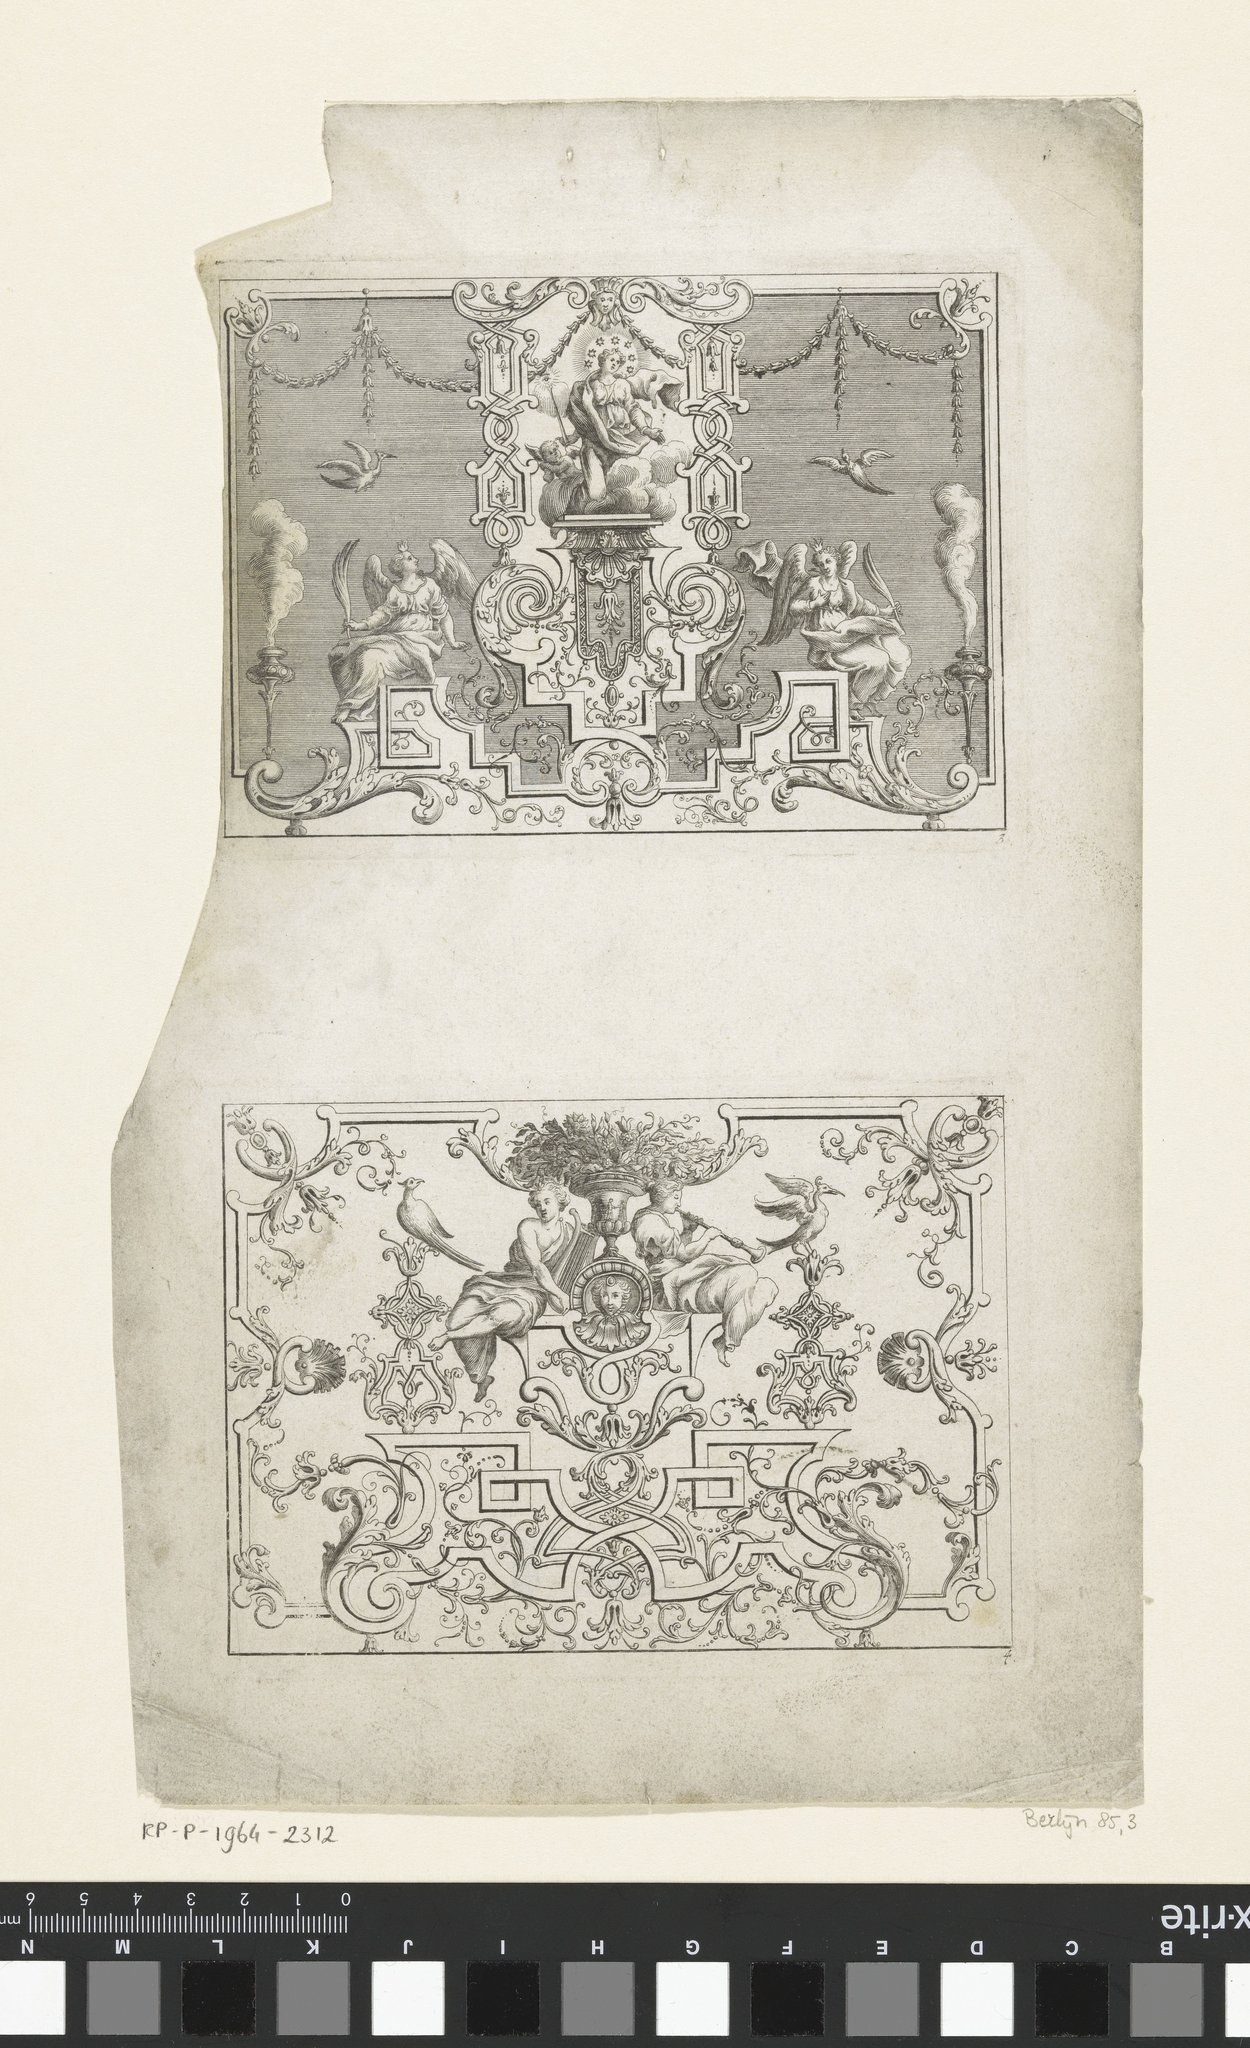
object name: print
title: Tronende vrouw en twee musicerende figuren bij een vaas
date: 1687-1725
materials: paper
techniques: etching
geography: germany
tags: ornament ~ grotesque, trees: palm-tree (+ leaf), lyre, cithara, psaltery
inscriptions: collector's mark: Lugt 2760, collector's mark: Lugt 2228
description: De bovenste prent bevat in het midden een tronende vrouw met een stralenkrans uit sterren en een staf met een stralend oog. Zij wordt geflankeerd door twee vrouwen met een palmtak en een vlam op hun voorhoofd. Links en rechts een rookvat. De onderste prent bevat een lier- en fluitspelende figuur aan weerszijden van een vaas en een omlijsting met grotesken.